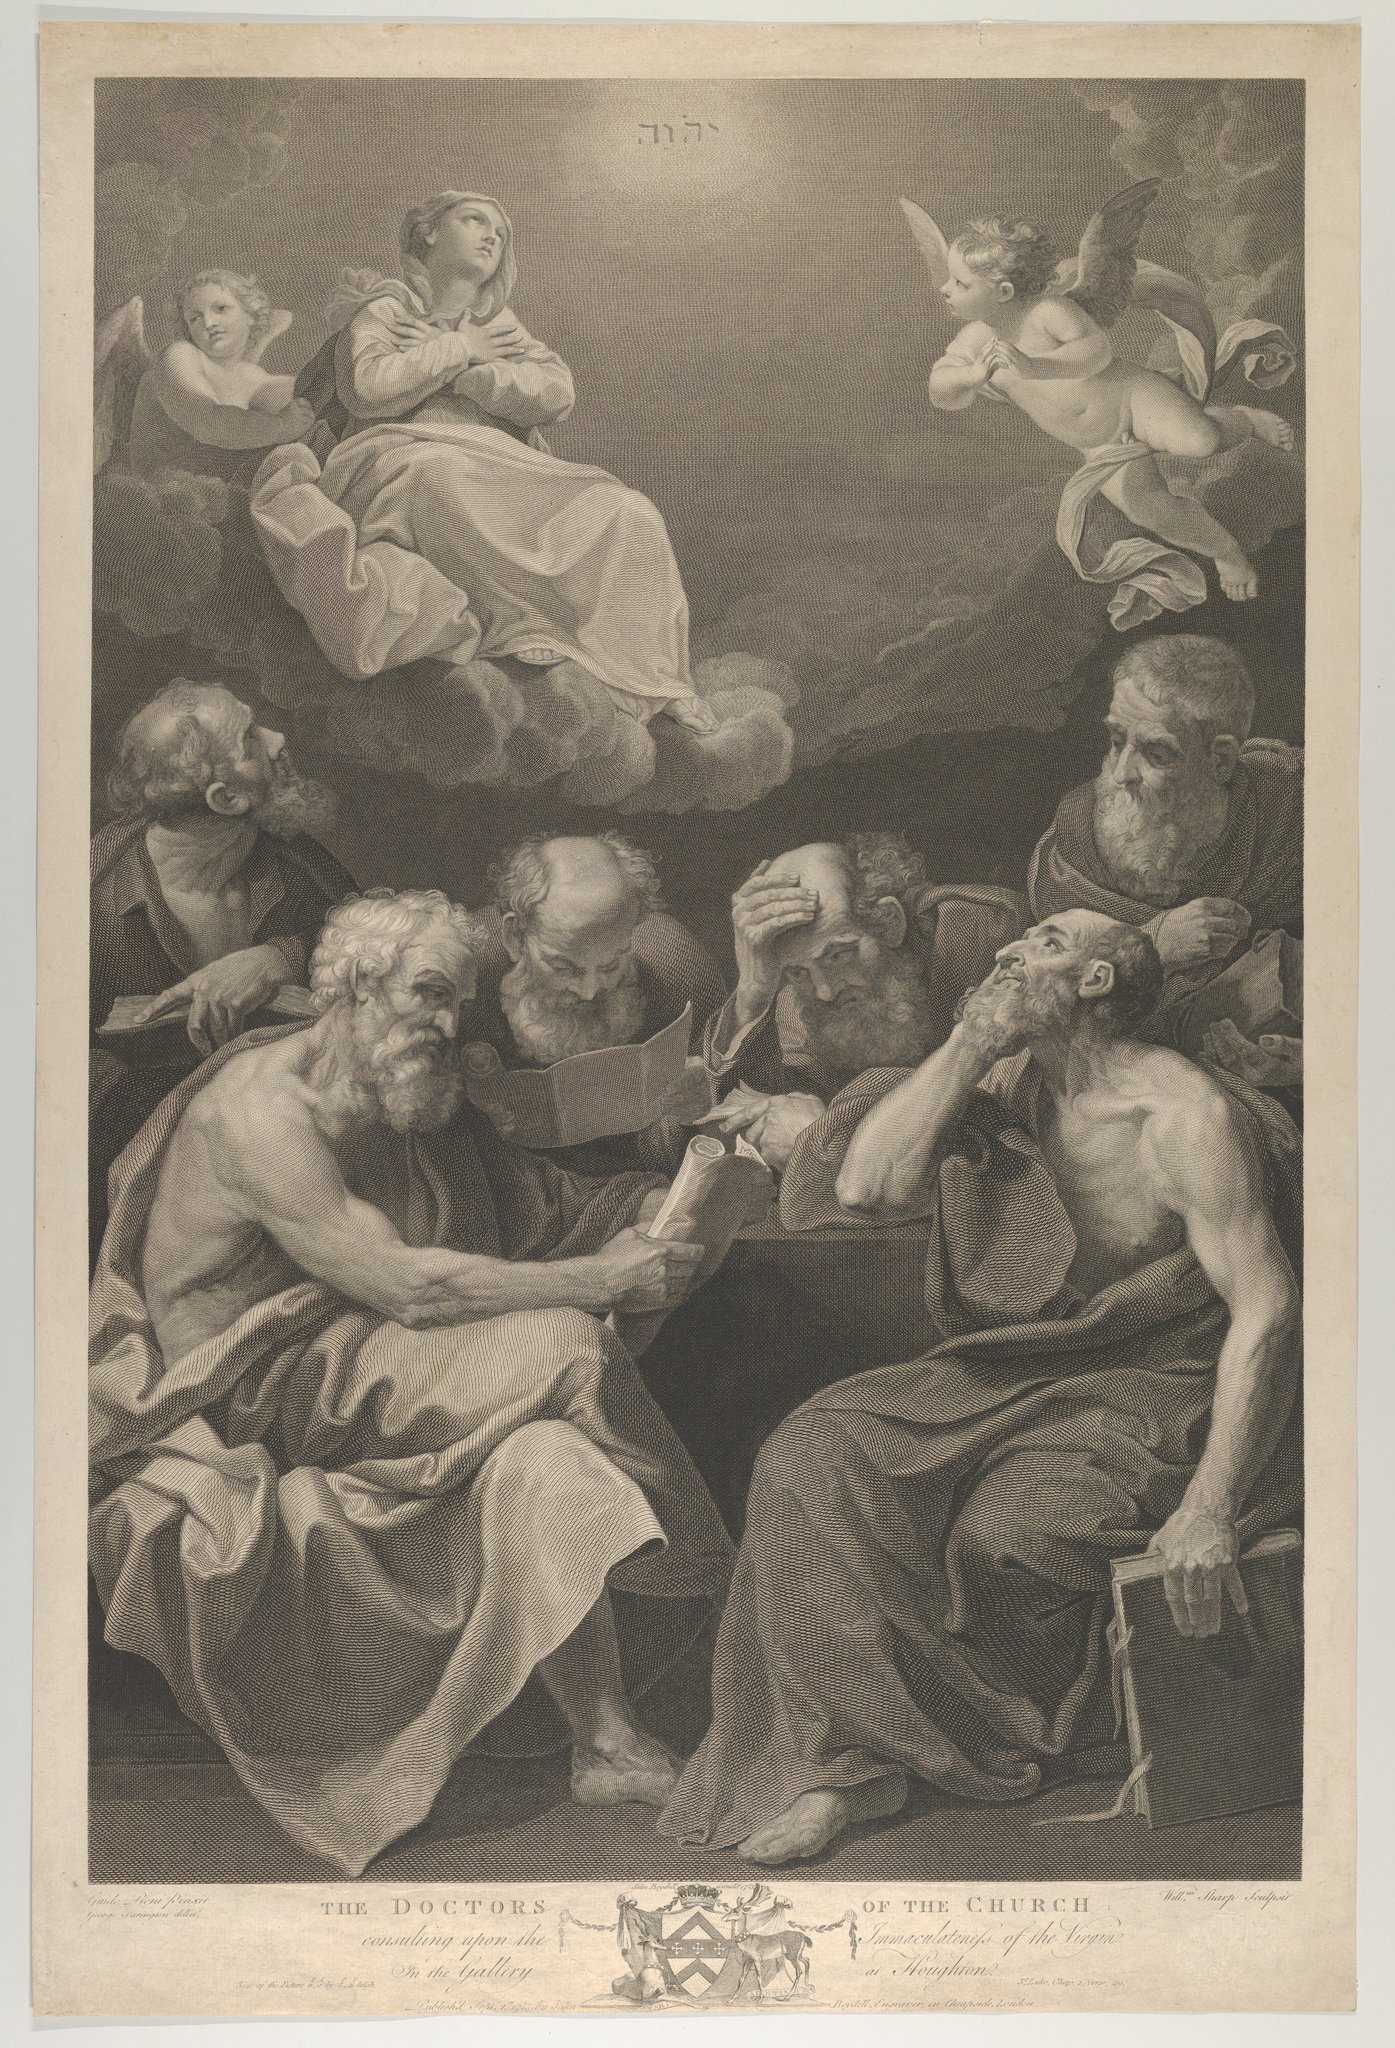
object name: print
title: The doctors of the church consulting books and documents and contemplating the Virgin who is shown above in heaven, flanked by angels, after Reni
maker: william sharp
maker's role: artist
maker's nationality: british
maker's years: 1749-1824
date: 1785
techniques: engraving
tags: men,angels,virgin mary